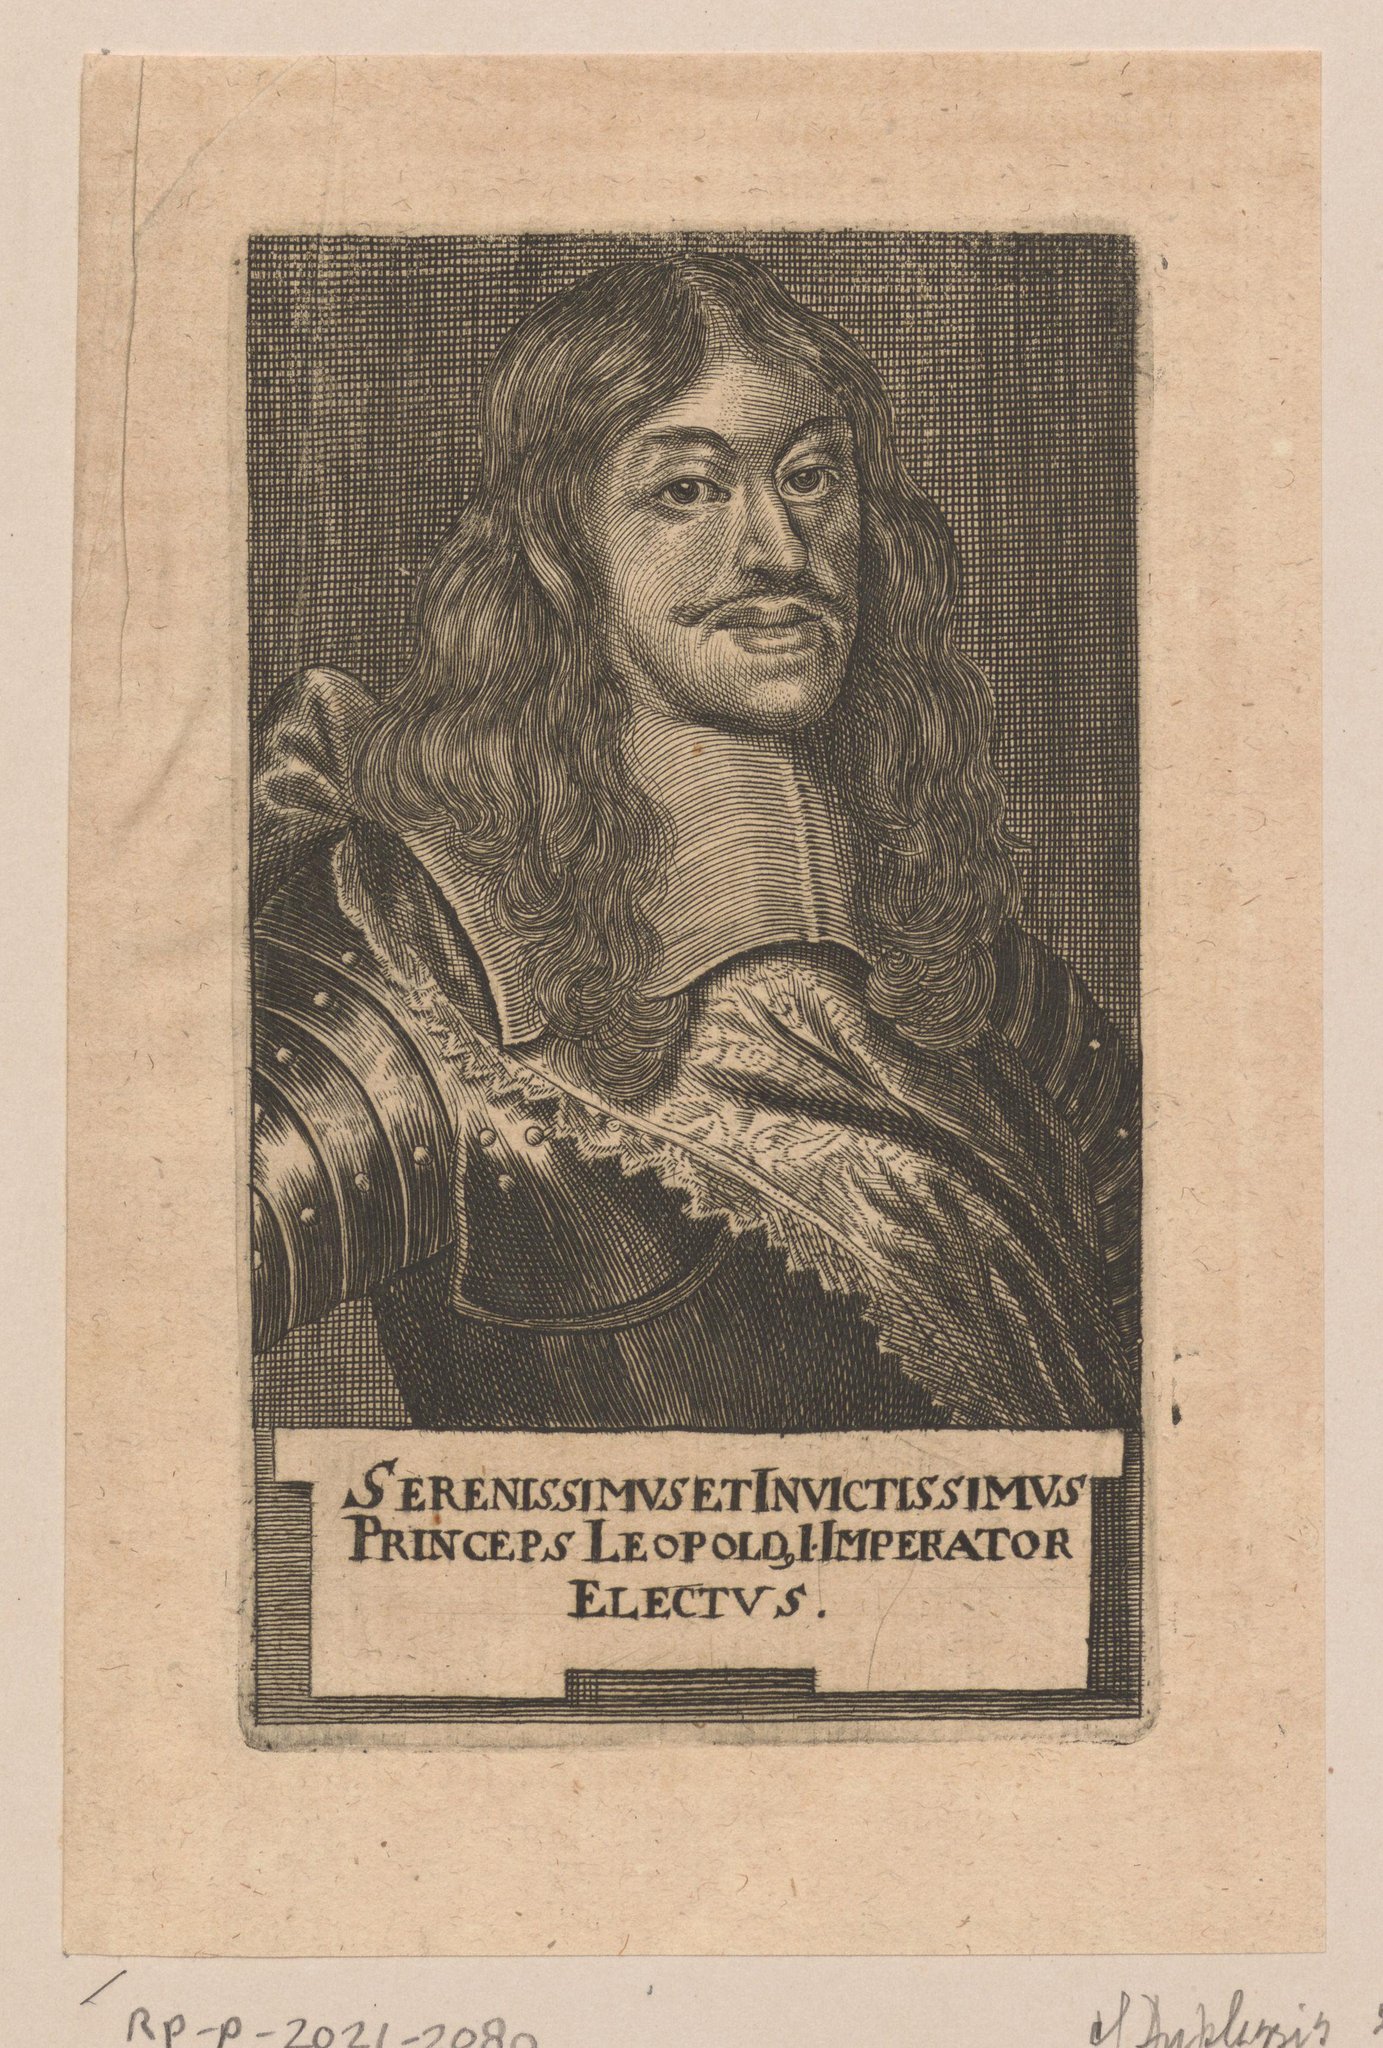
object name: print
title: Portret van keizer Leopold I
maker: Anonymous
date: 1665-1720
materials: paper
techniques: engraving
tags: leopold i (keizer van duitsland), armour, historical persons, emperor